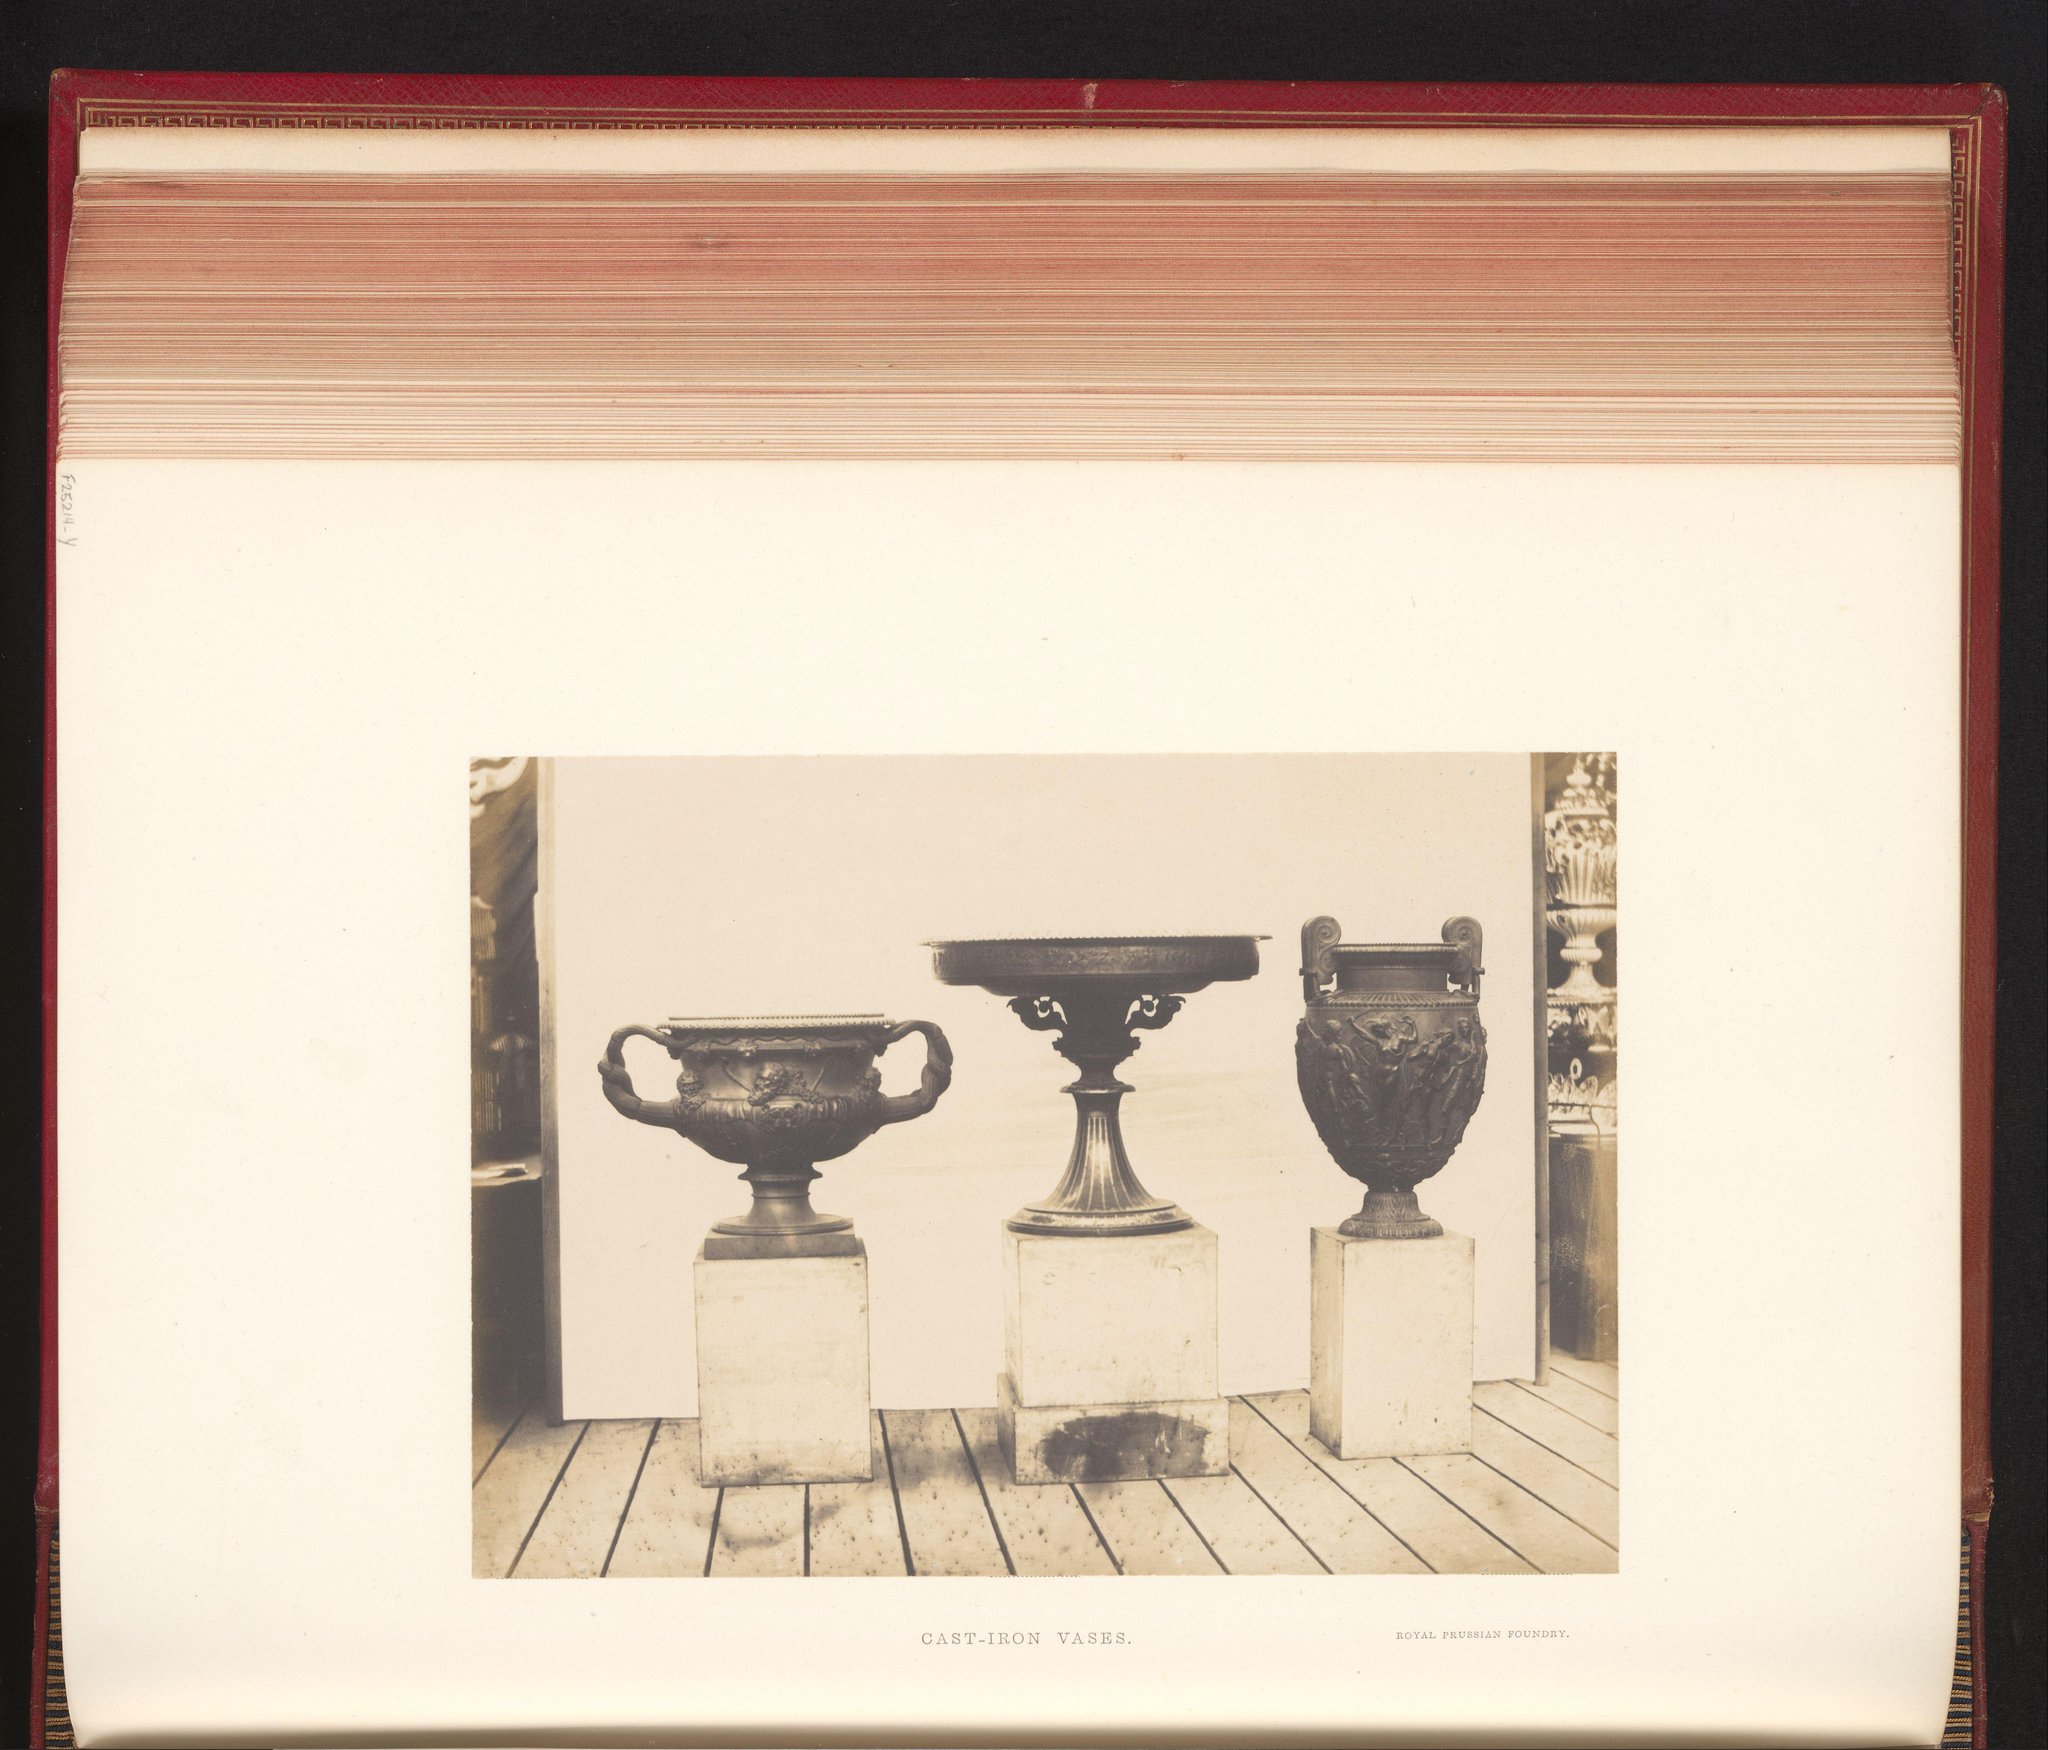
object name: photograph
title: Drie gietijzeren vazen van de Royal Prussian tentoongesteld op de Great Exhibition of the Works of Industry of All Nations van 1851 in Londen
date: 1851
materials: photographic support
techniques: salted paper print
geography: london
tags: container of metal: bucket, can, canister, drum, tin, london